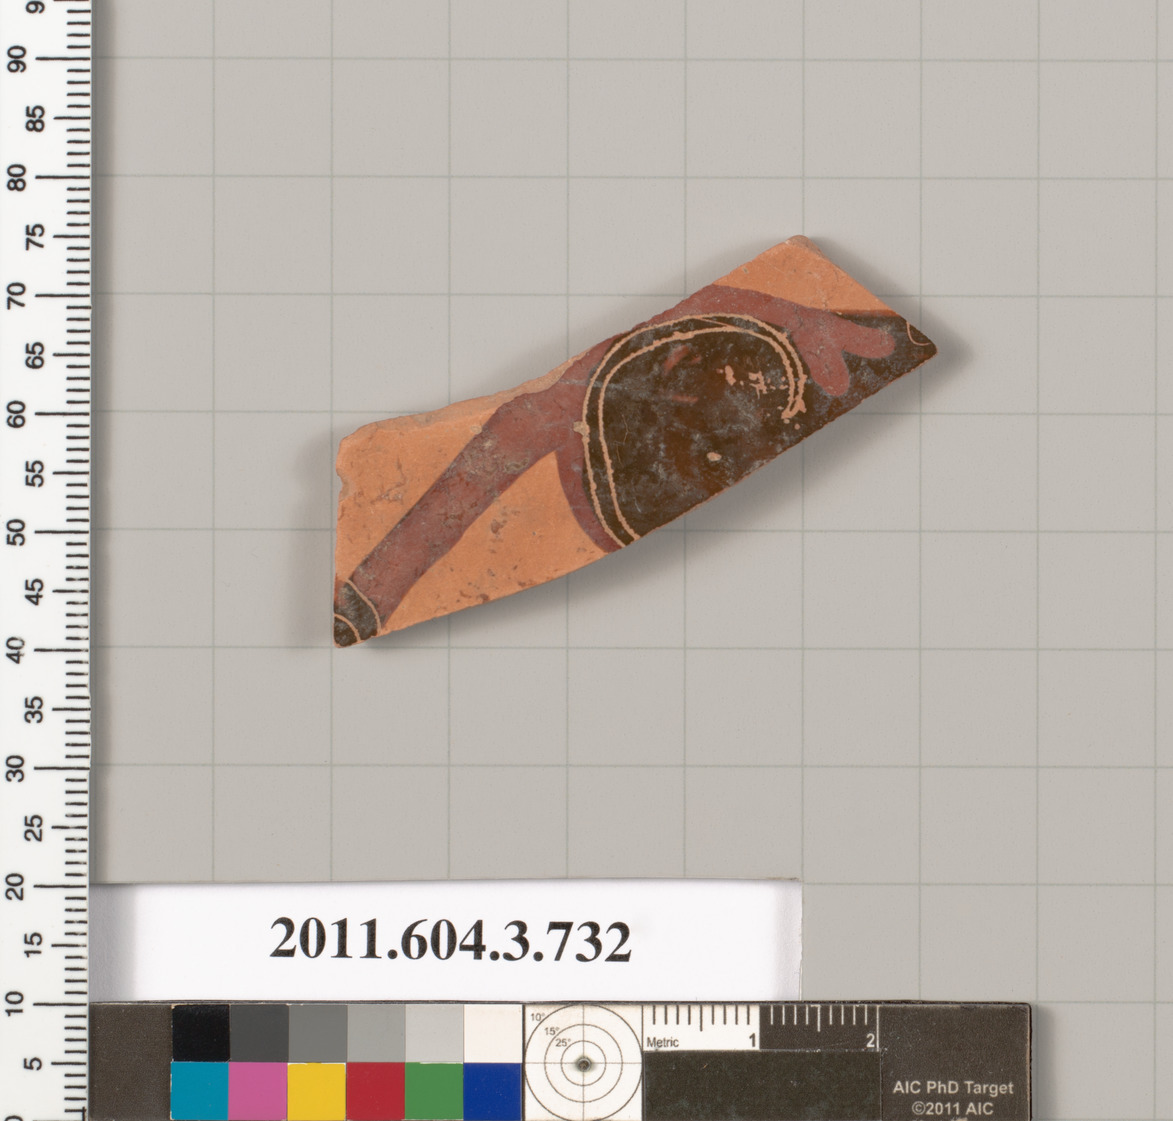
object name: neck amphora, tyrrhenian fragment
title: Terracotta fragment of a neck-amphora (jar)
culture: greek, attic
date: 575-551 BCE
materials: terracotta